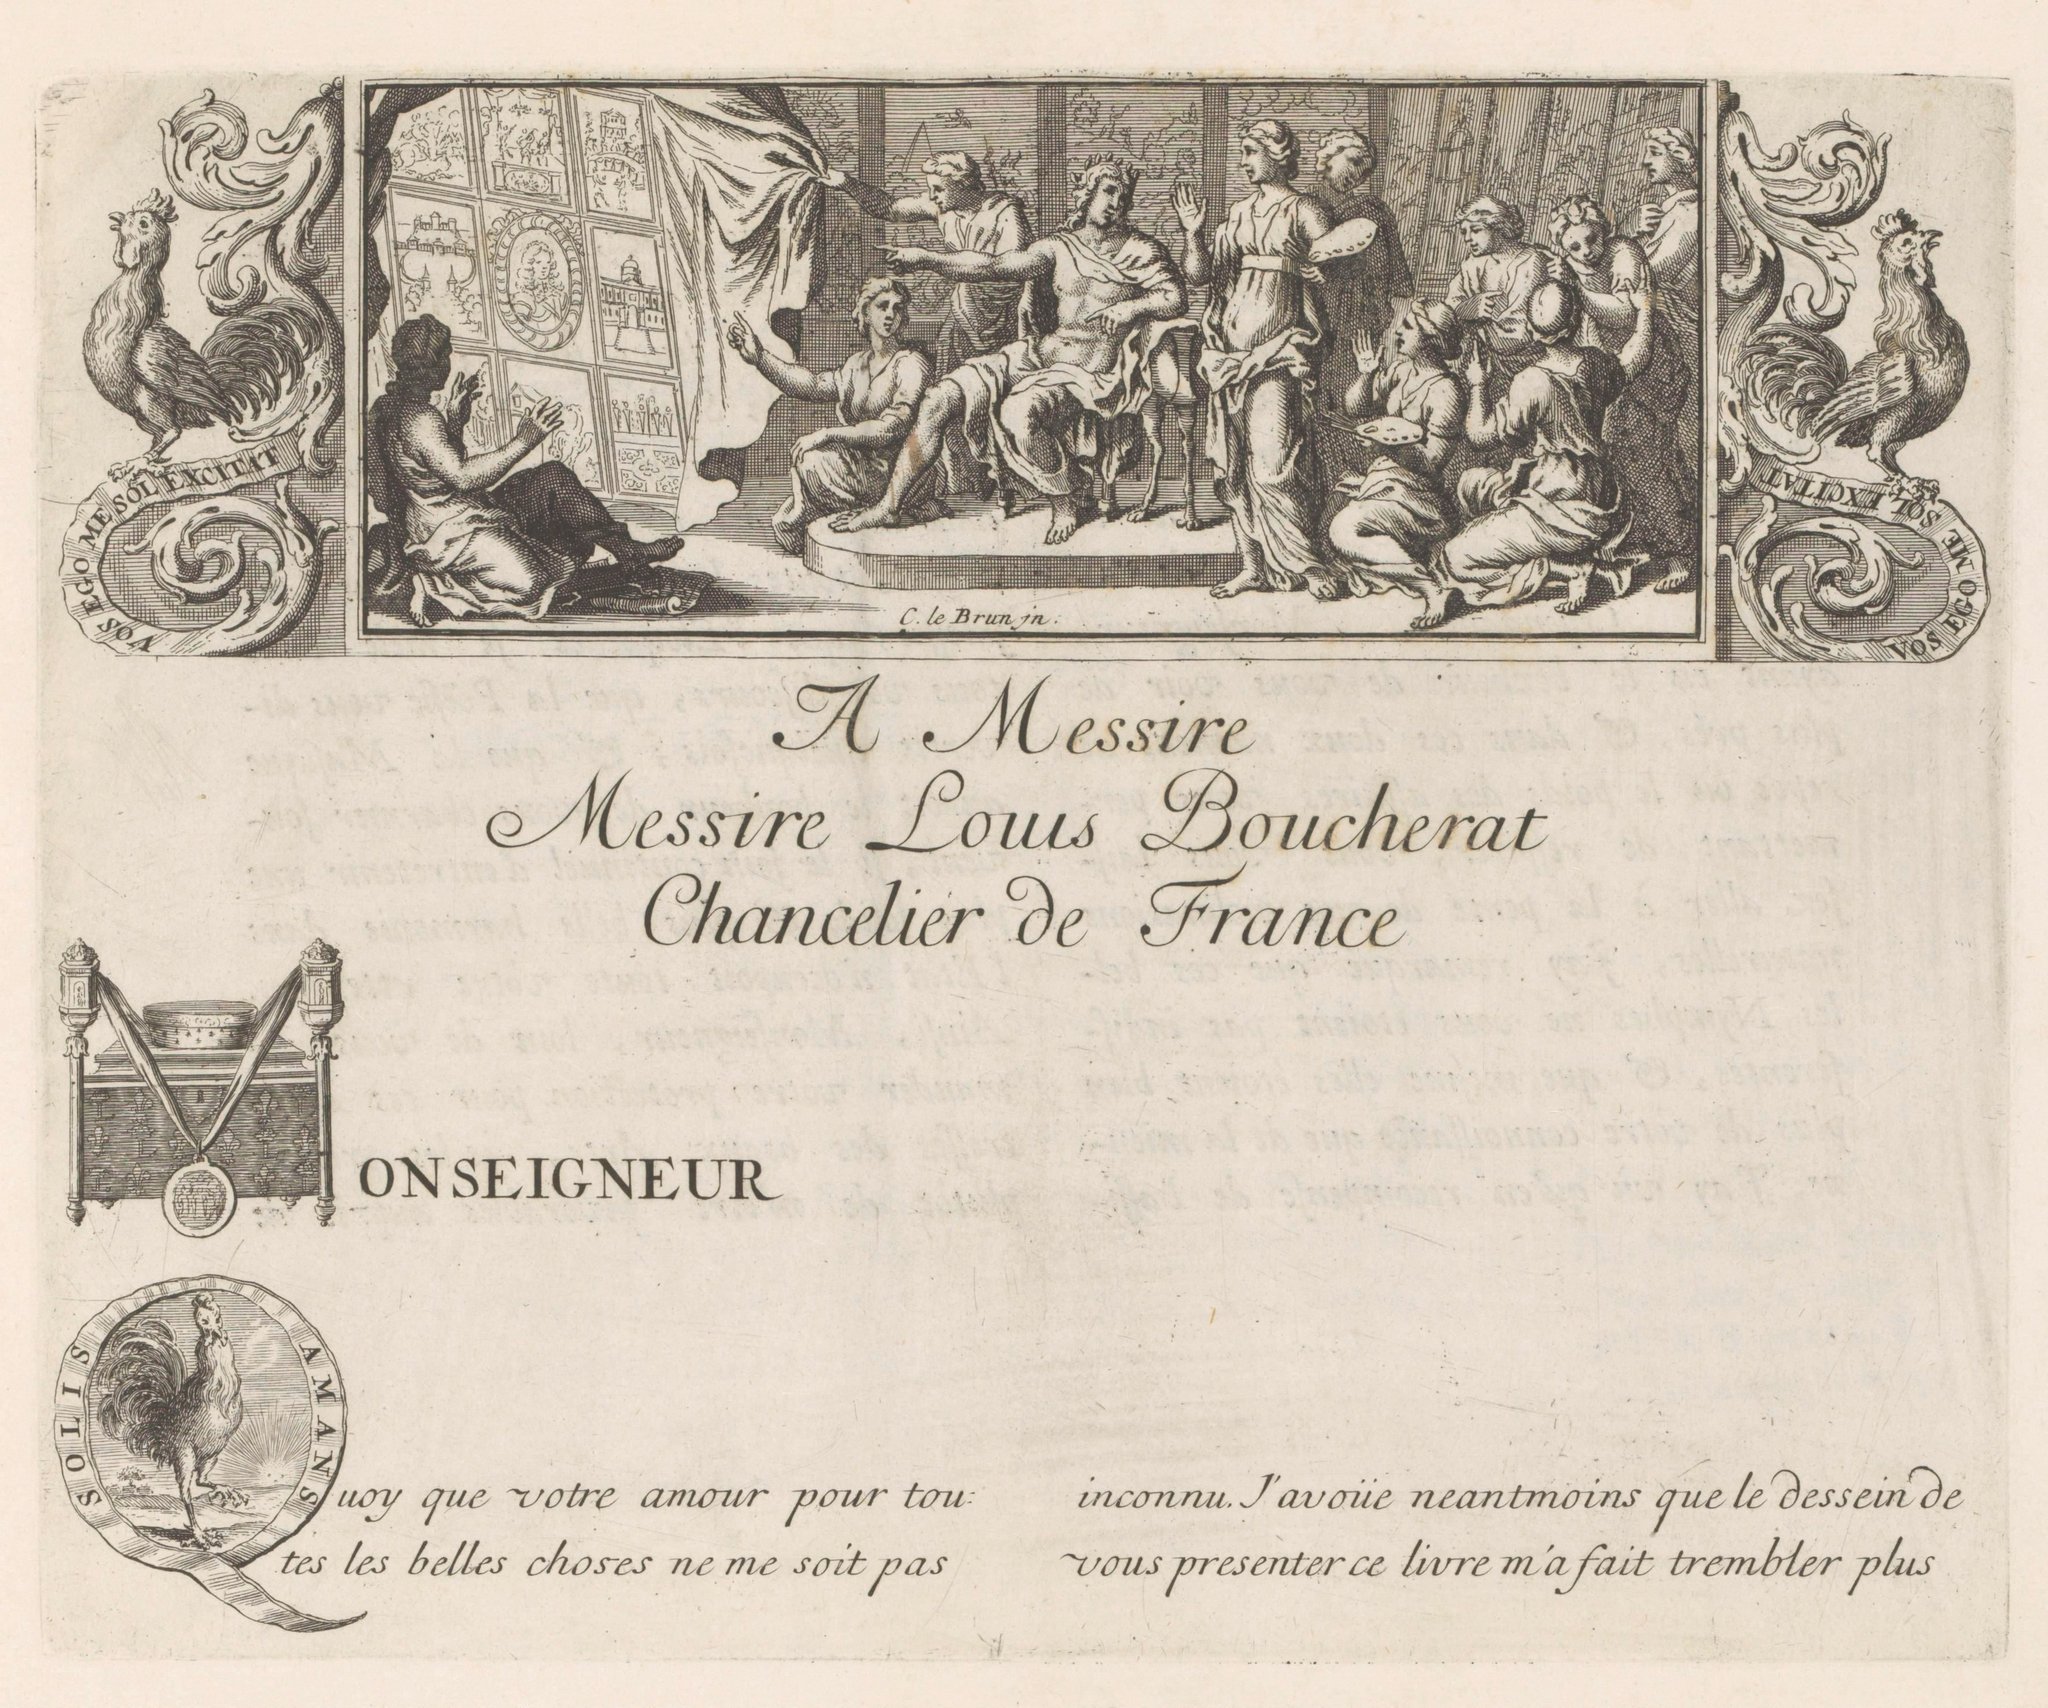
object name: album leaf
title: Le Cabinet des Beaux Arts, ou Recueil Des Plus Belles Estampes, gravées d'aprés les Tableaux Originaux (...)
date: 1695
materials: paper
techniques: engraving, etching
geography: paris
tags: louis boucherat, apollo and the muses, apollo musagetes, 'pictura', symbolic representations, allegories and emblems ~ painting; 'pittura' (ripa)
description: Apollo, omringd door de muzen, wijst op een veelluik met verschillende voorstellingen. Bij hem staat de personificatie van de Schilderkunst met palet en kwasten in de hand. Links en rechts naast deze voorstelling een haan met banderol. Onder de voorstelling de opdracht van dit album aan Louis Boucherat, kanselier van Frankrijk, in het Frans. De initiaal M wordt gevormd door de attributen van het kanselierschap. In de initiaal Q een haan uit het wapenschild van Louis Boucherat. Prent maakt deel uit van een album.